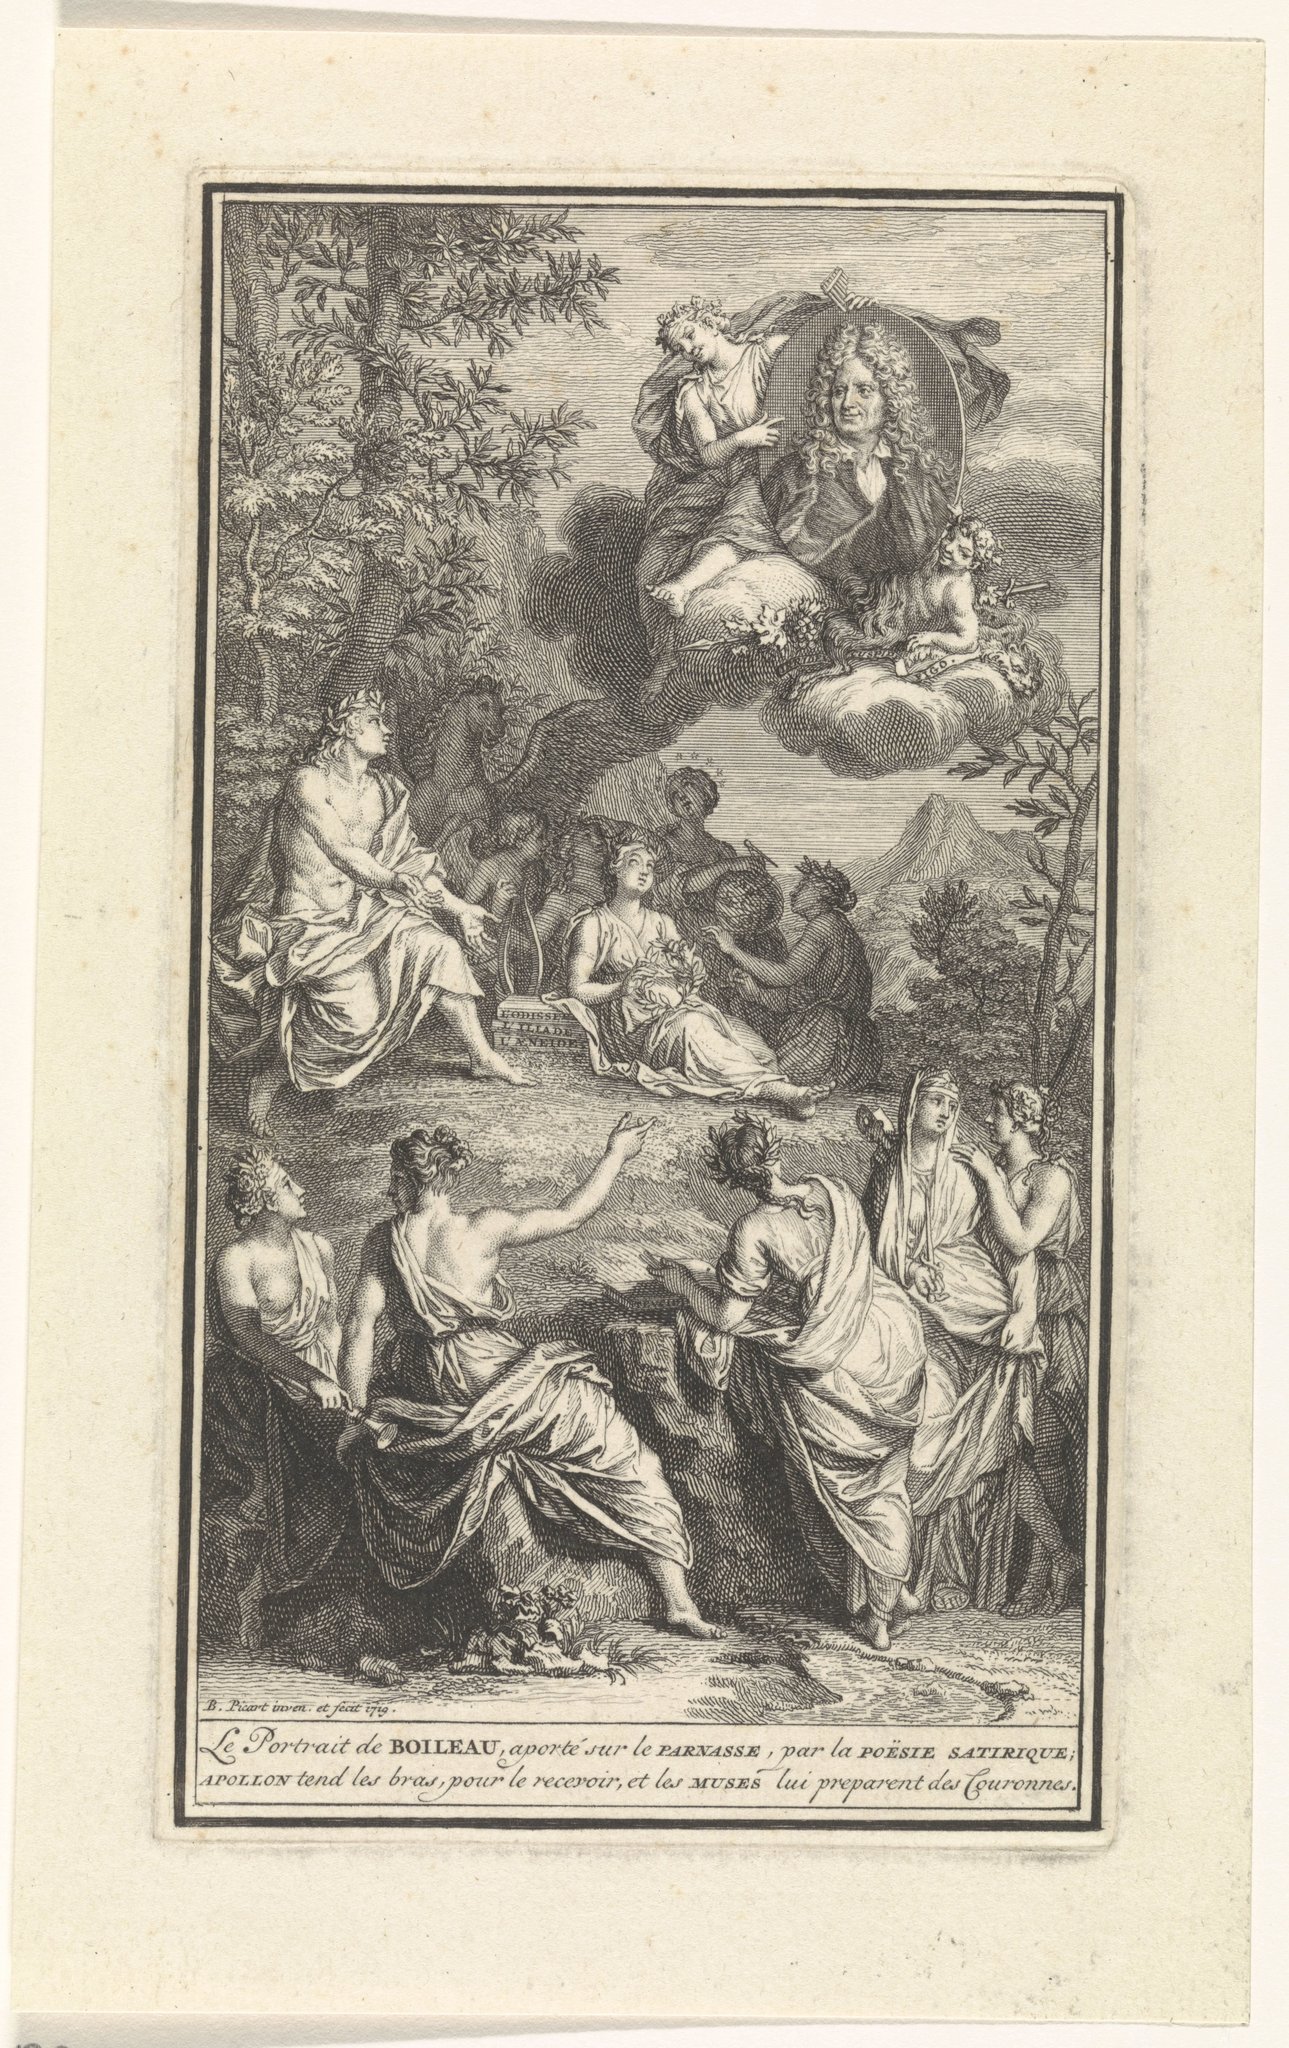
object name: titelprent, frontispice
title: Portret van Nicolas Boileau naar de Parnassus gedragen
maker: bernard picart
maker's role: draughtsman, print maker, publisher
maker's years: 1673-1733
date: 1719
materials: paper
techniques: engraving, etching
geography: amsterdam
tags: paris, nicolas boileau, apollo and the muses, apollo musagetes, parnassus, sacred to apollo musagetes, symbolic representations, allegories and emblems ~ satirical poetry; 'poema satirico' (ripa), writer, poet, author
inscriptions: collector's mark: Lugt 240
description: Satirische Poëzie draagt het portret van de Franse schrijver Nicolas Boileau naar de Parnassus. Op de berg wachten Apollo en de muzen, die het portret van de schrijver zullen lauweren.